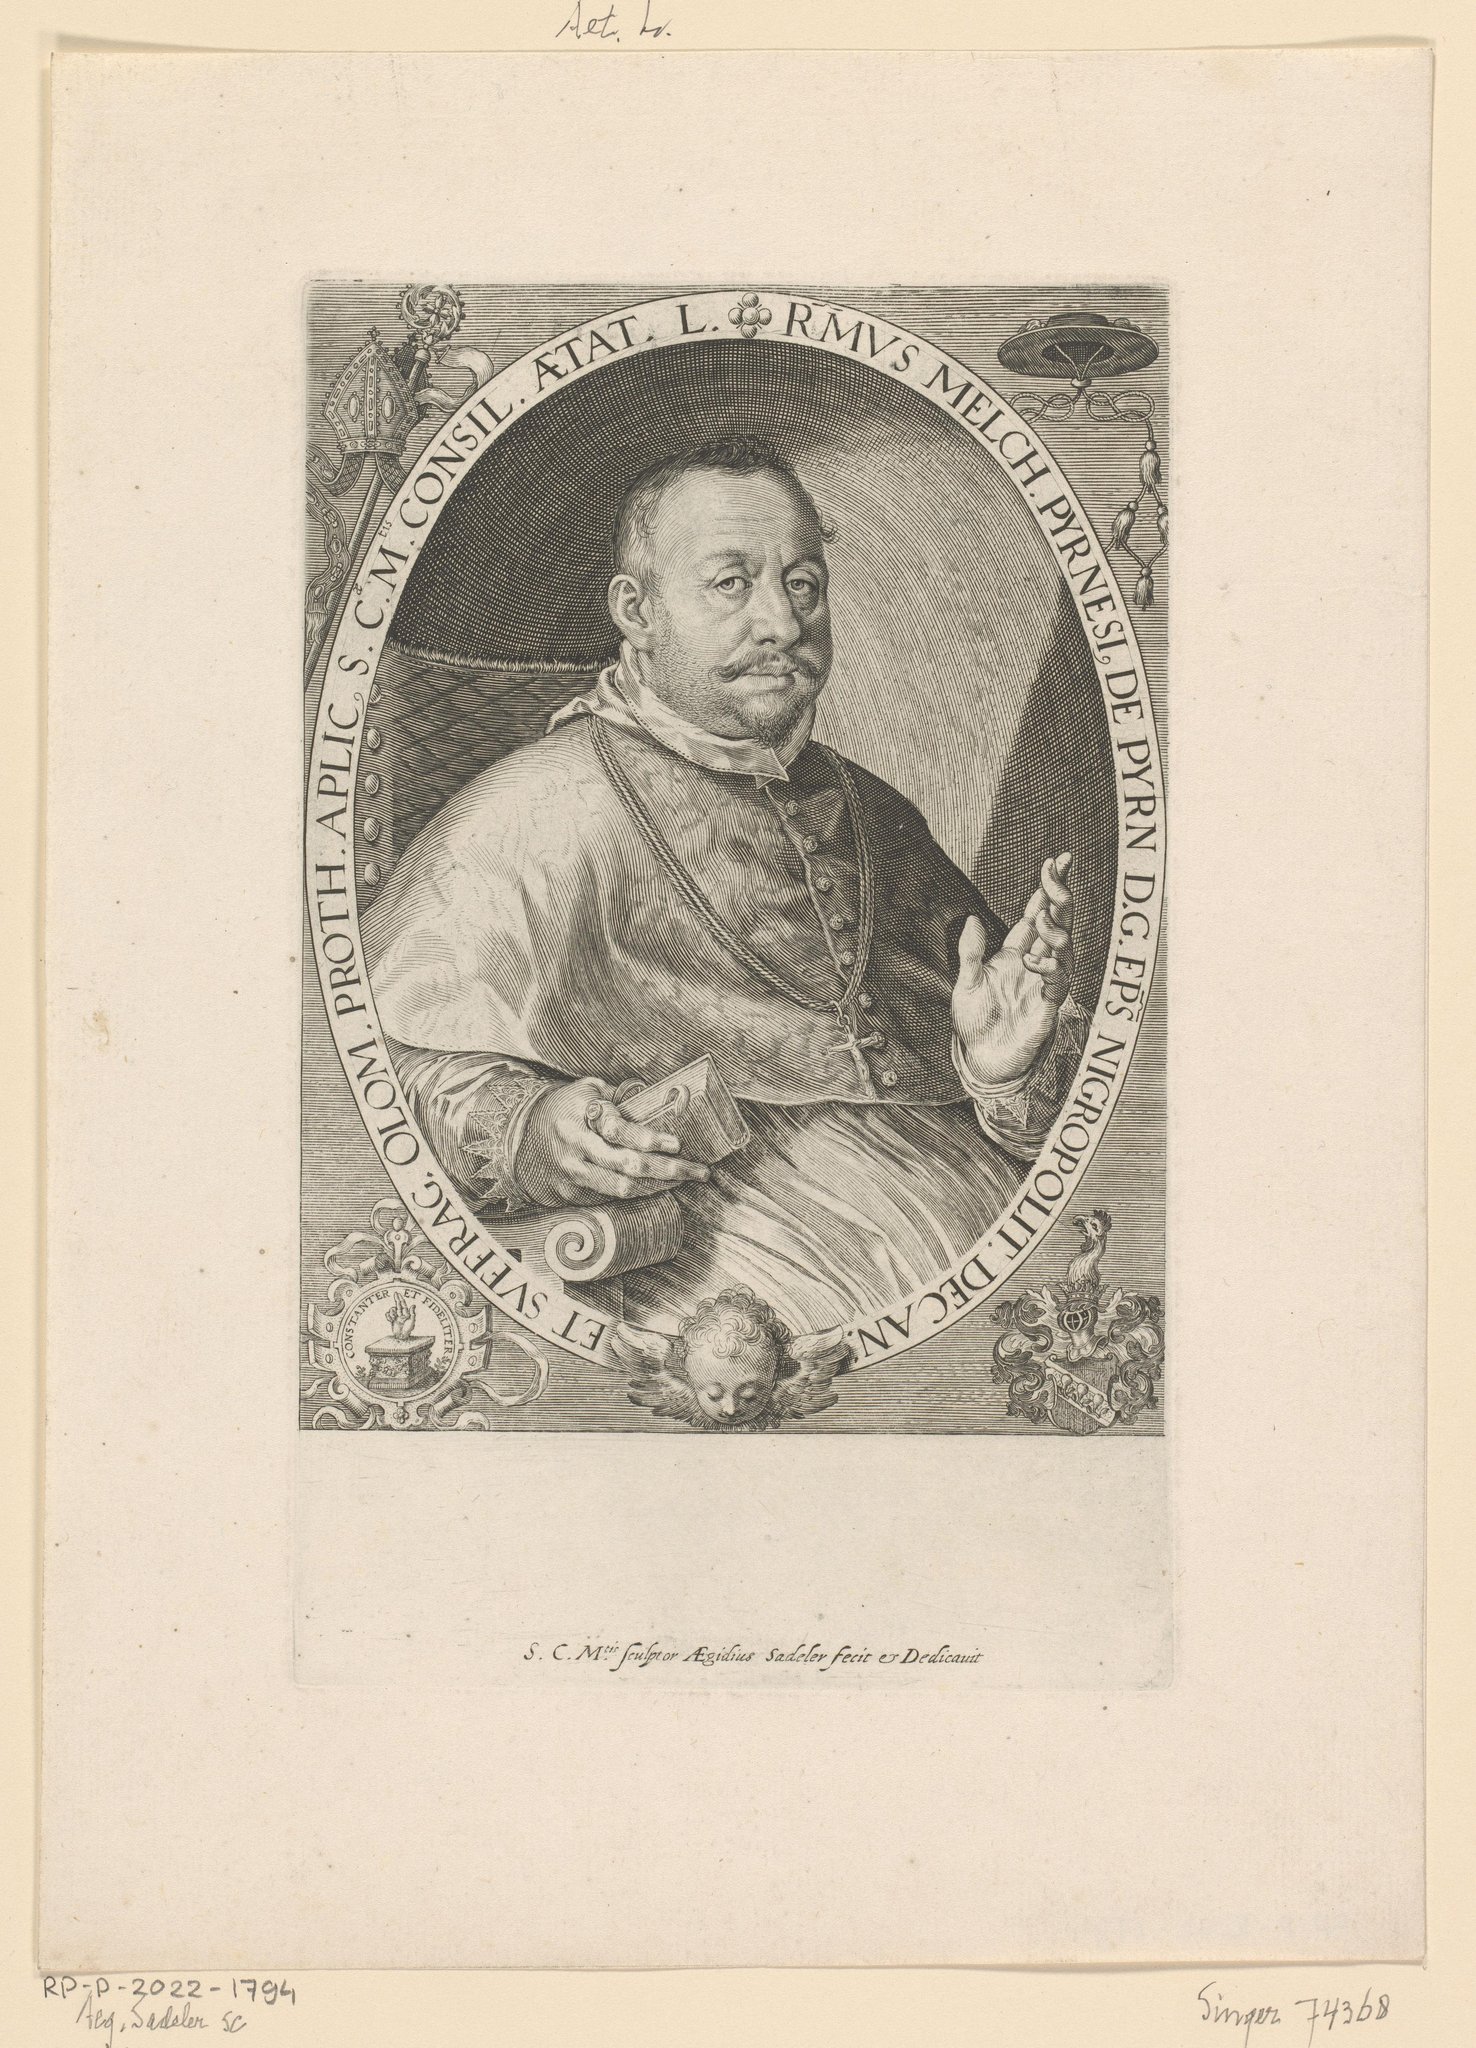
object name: print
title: Portret van Melchior Pyrnesius van Pyrn op 50-jarige leeftijd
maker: aegidius sadeler (ii)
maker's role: draughtsman, print maker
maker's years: 1568-1629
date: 1600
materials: paper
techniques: engraving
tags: archbishop, bishop, etc. (roman catholic), historical persons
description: Met tekst in het Latijn rondom het portret.